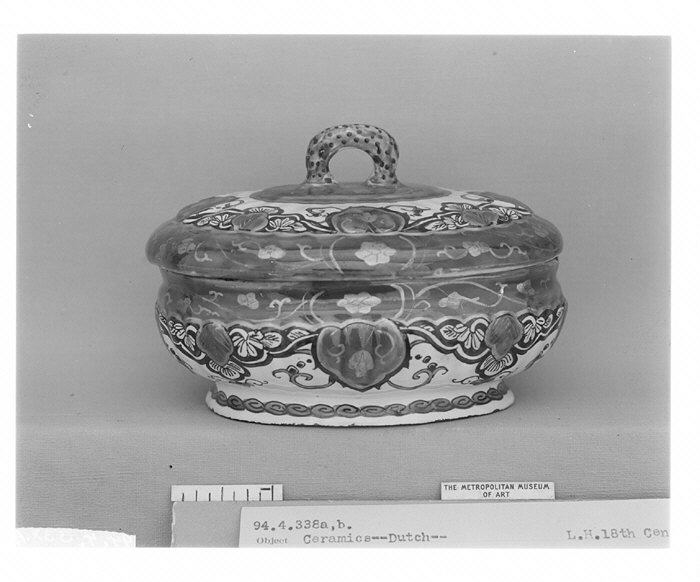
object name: sweetmeat box and cover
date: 1801-1900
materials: earthenware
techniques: glazing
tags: flowers,leaves